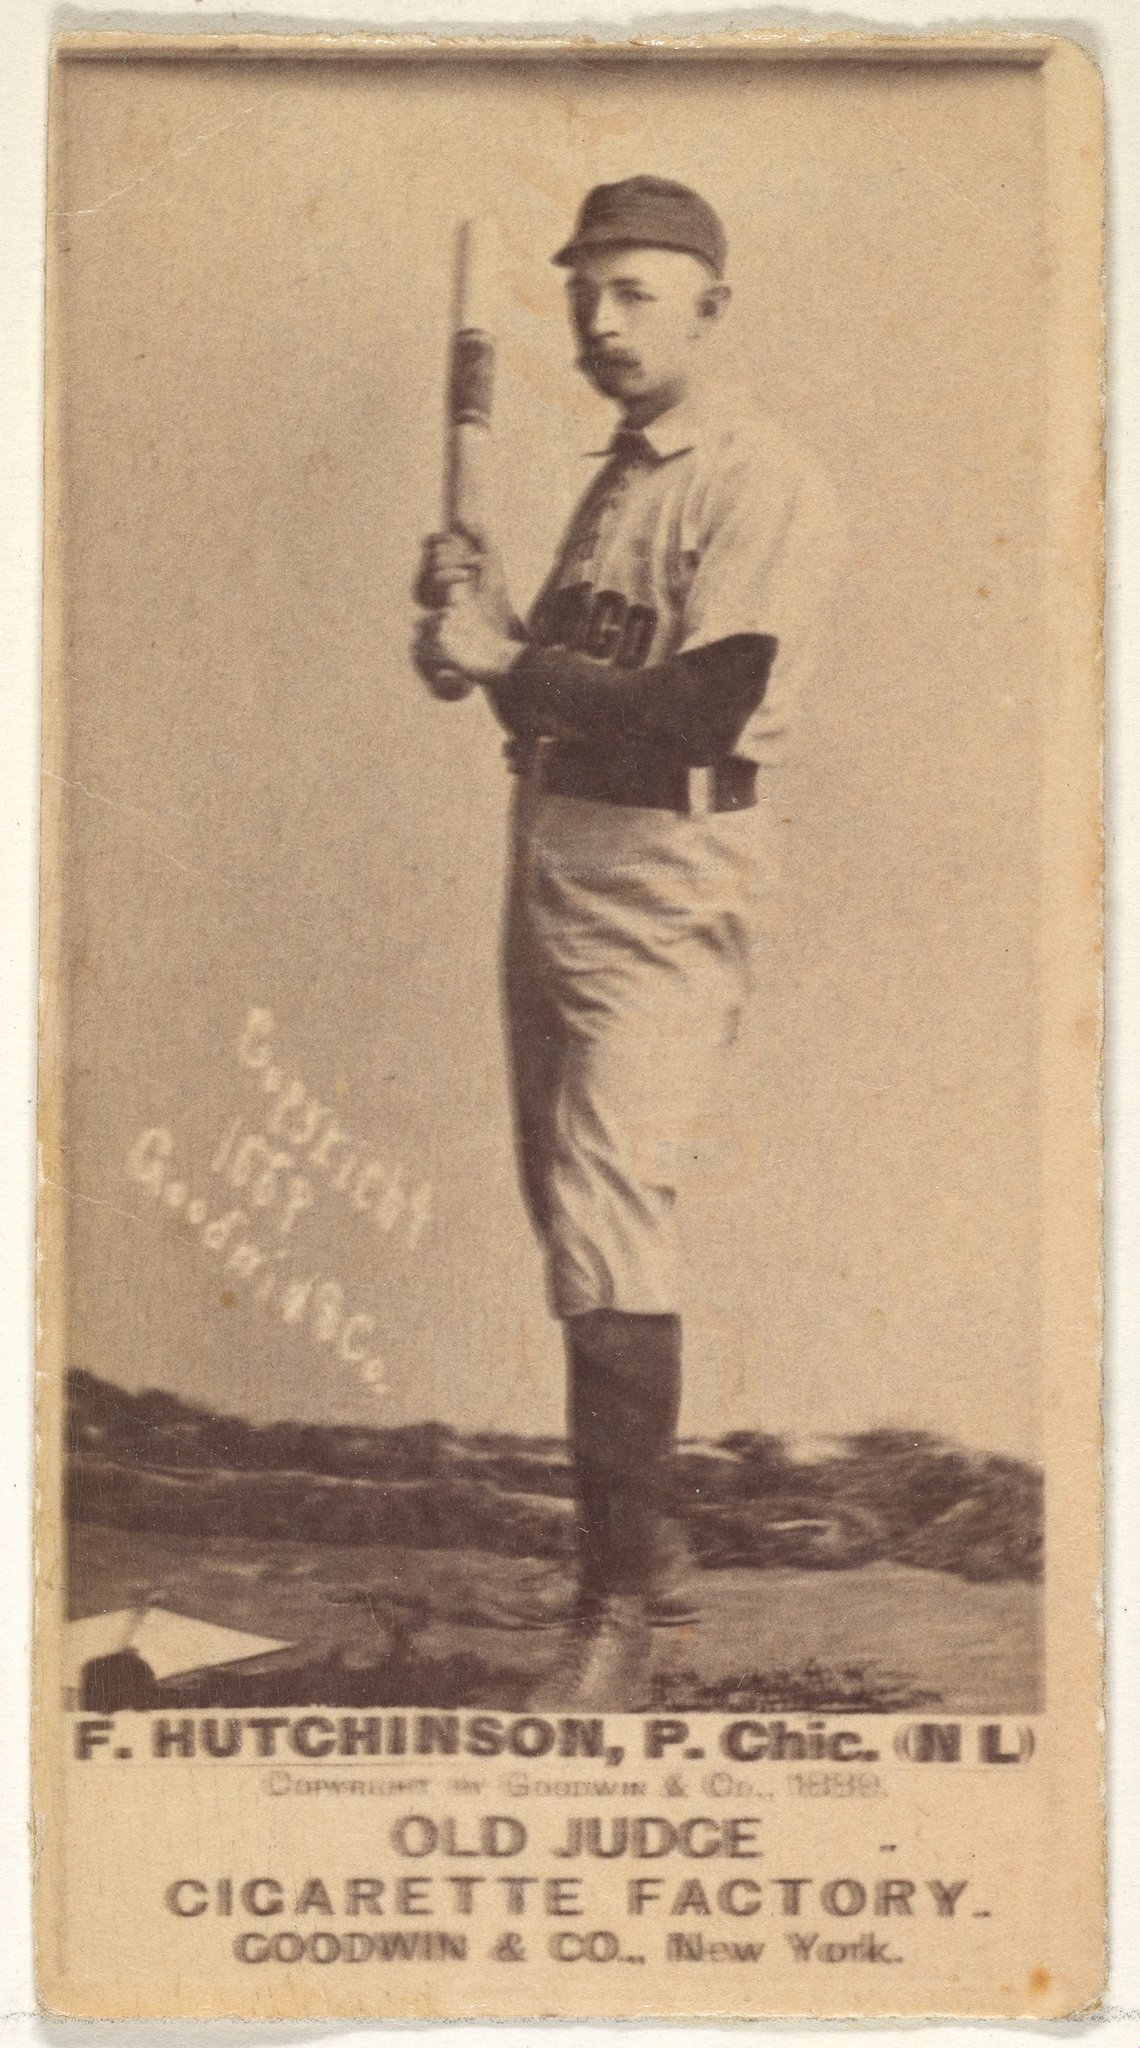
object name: baseball card, photograph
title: F. Hutchinson, Pitcher, Chicago, from the Old Judge series (N172) for Old Judge Cigarettes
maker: goodwin & company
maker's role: publisher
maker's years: 1850-1950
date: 1887-1890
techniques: albumen silver print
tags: men,portraits,baseball,athletes